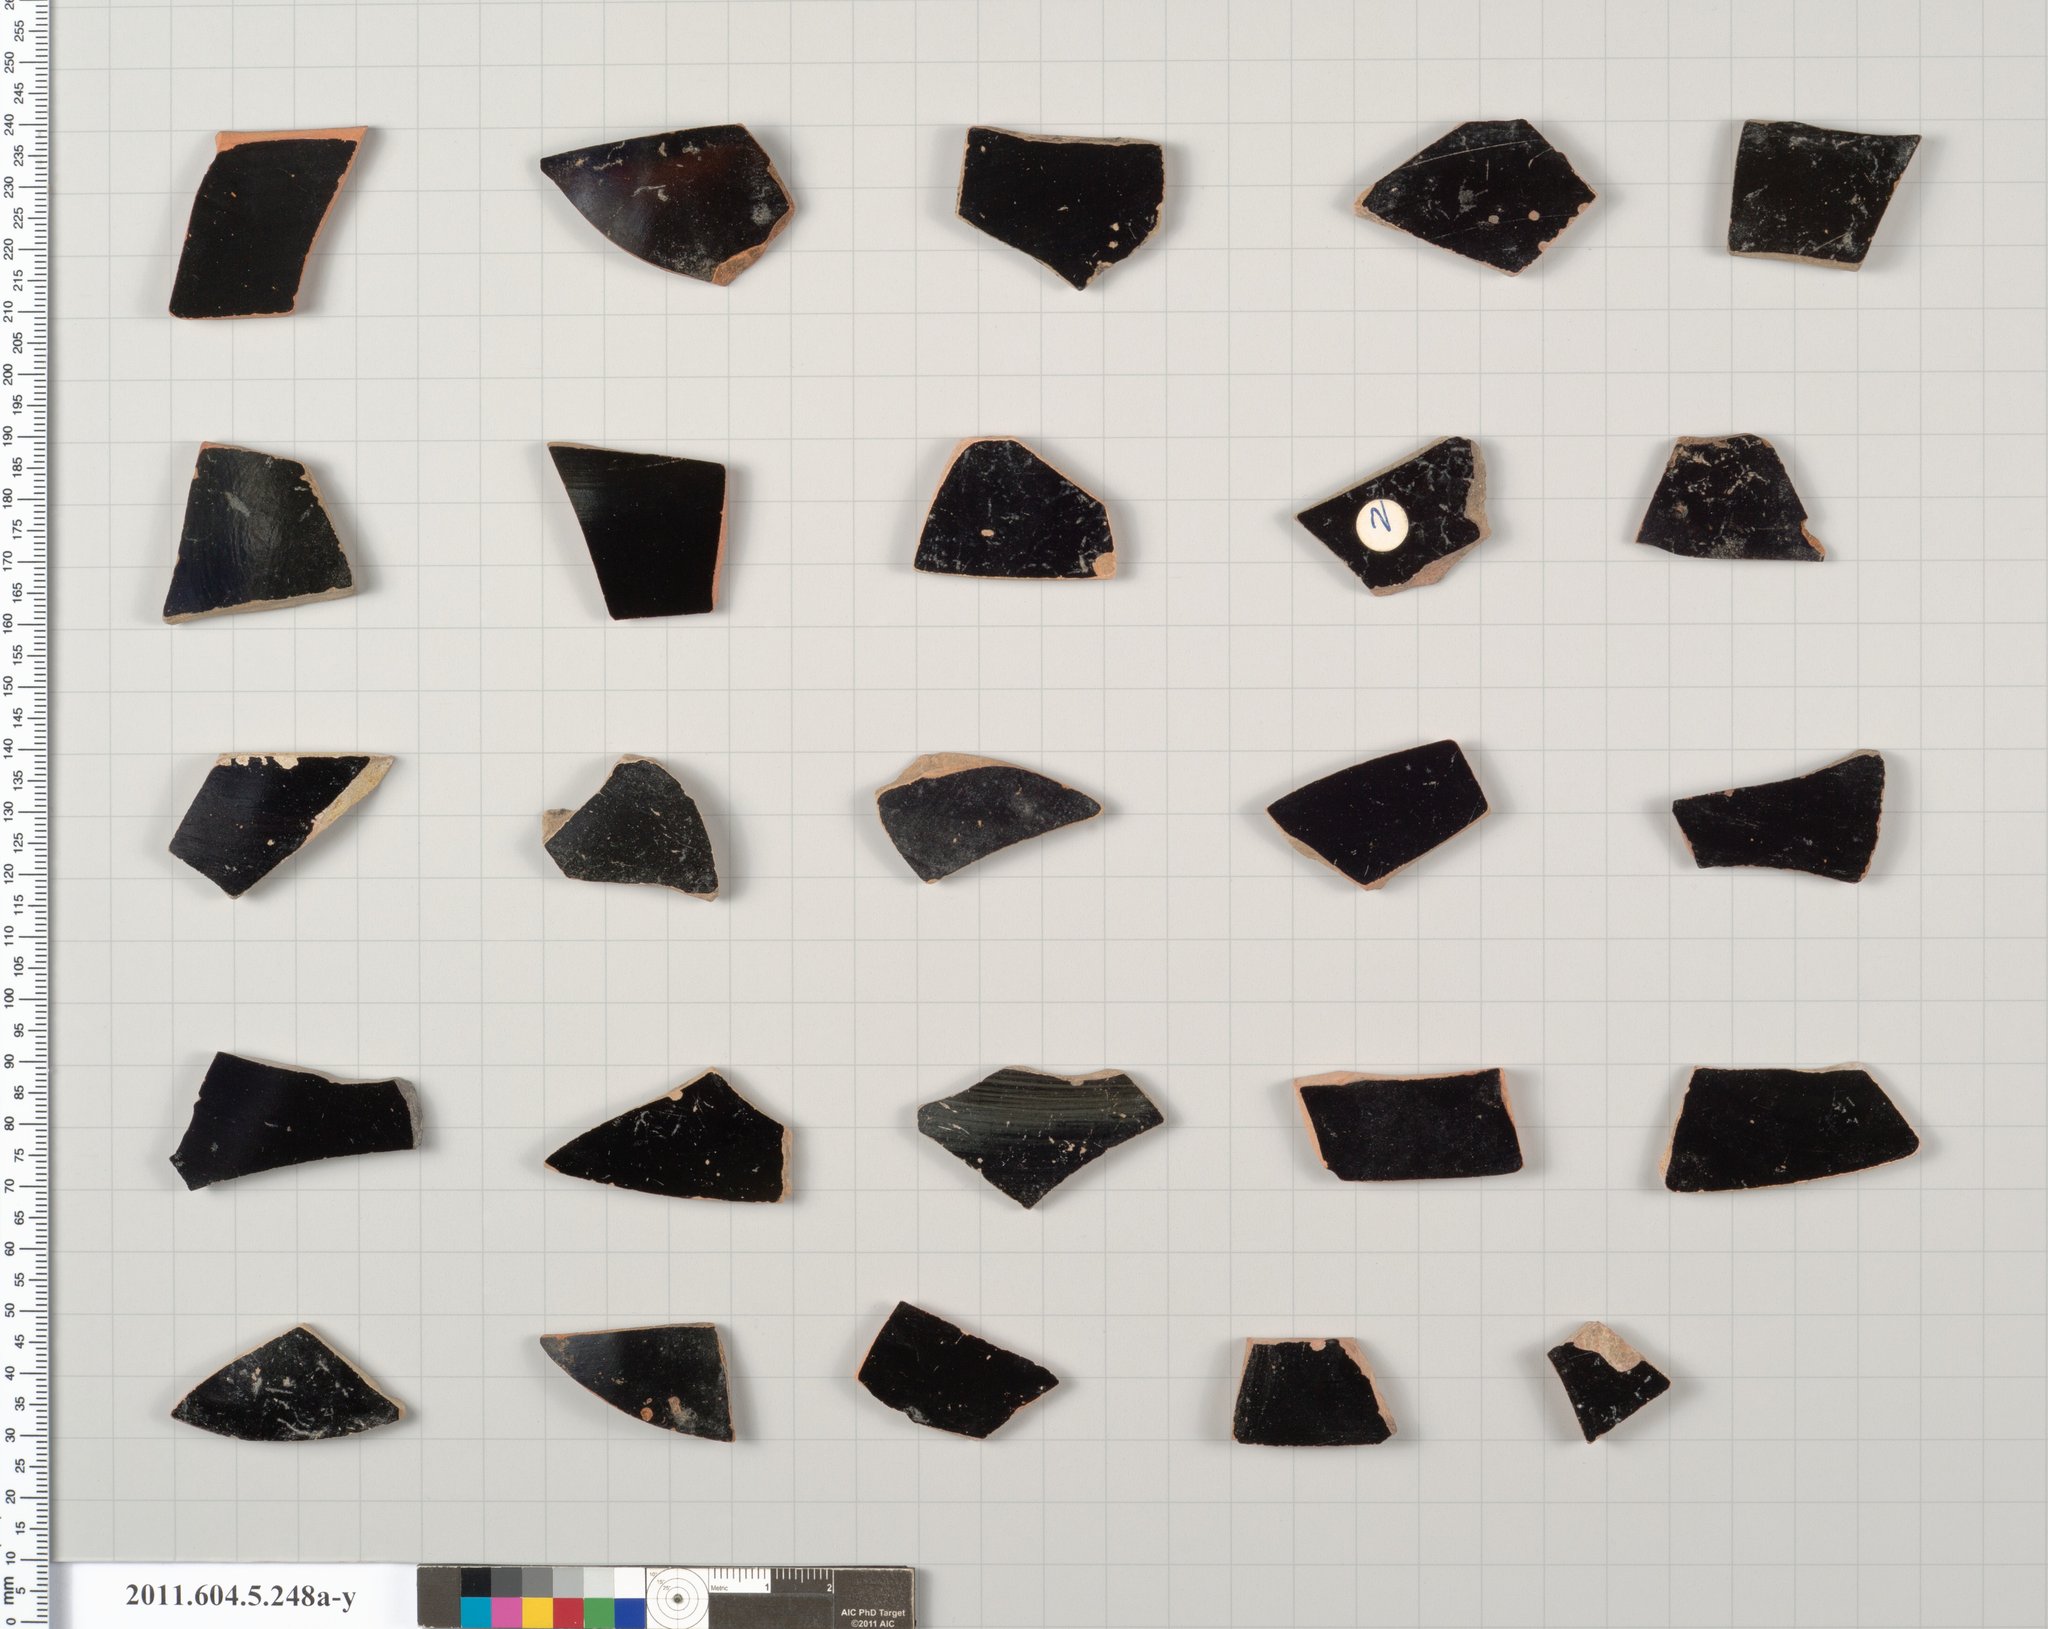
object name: kylix fragment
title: Terracotta fragments of kylikes (drinking cups)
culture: greek, attic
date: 600-401 BCE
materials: terracotta